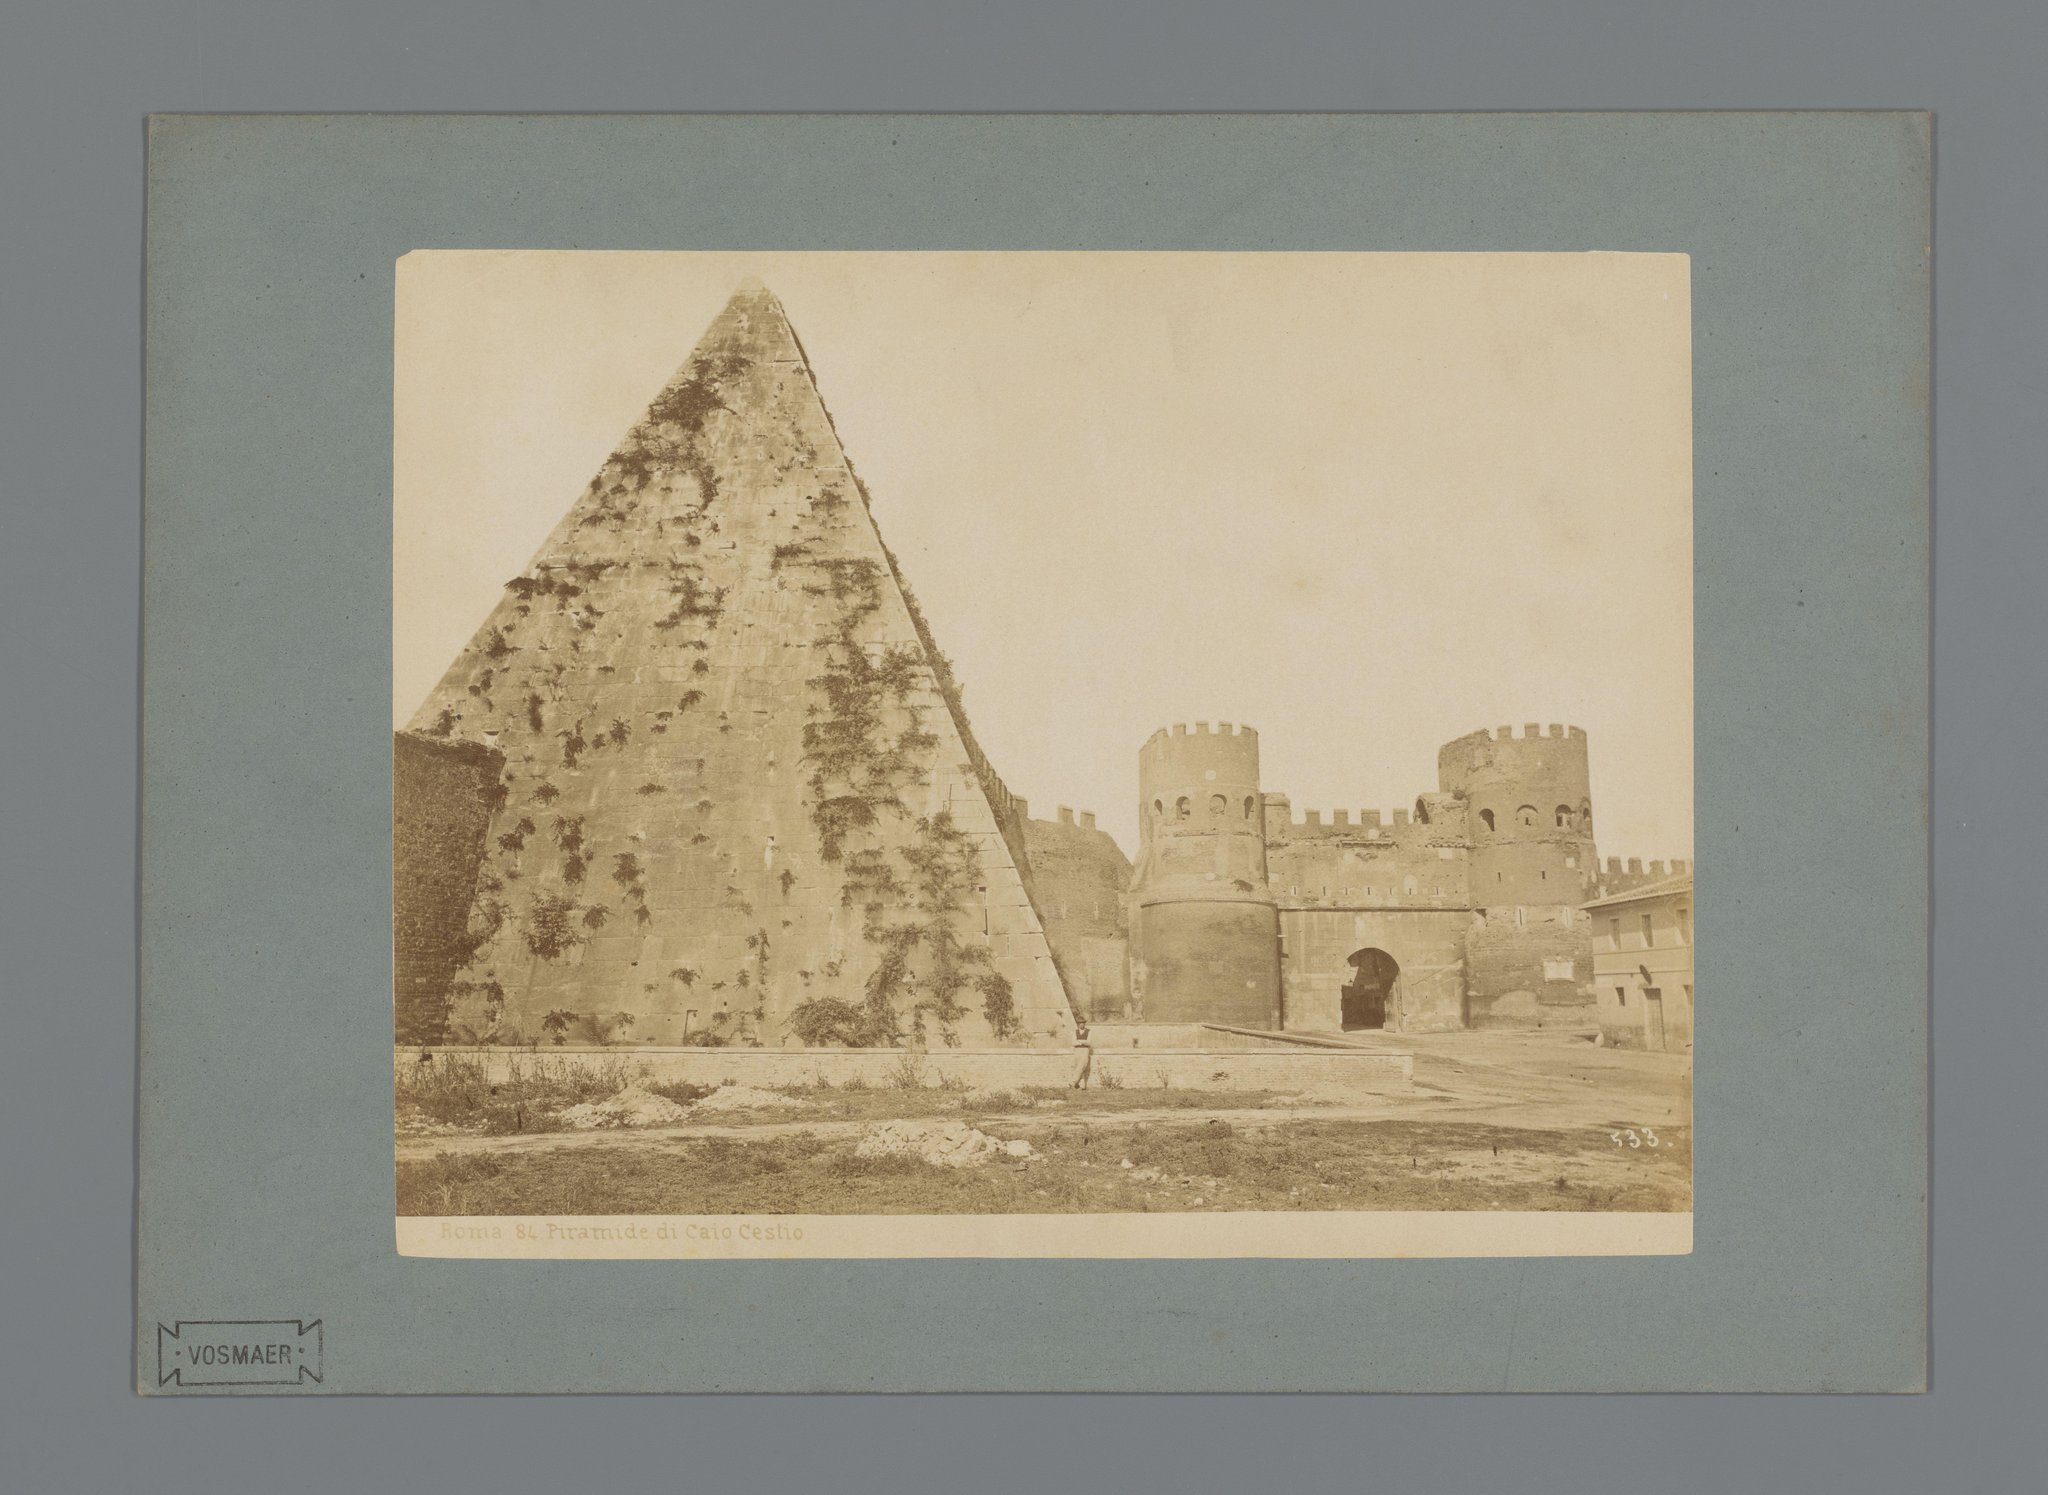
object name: photograph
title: Piramide van Cestius te Rome, Italië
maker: Anonymous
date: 1851-1890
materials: cardboard, paper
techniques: albumen print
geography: rome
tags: pyramid (historical grave form), city-gate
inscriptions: number: ‘84.’, collector's mark: ‘VOSMAER’, number: ‘533.’